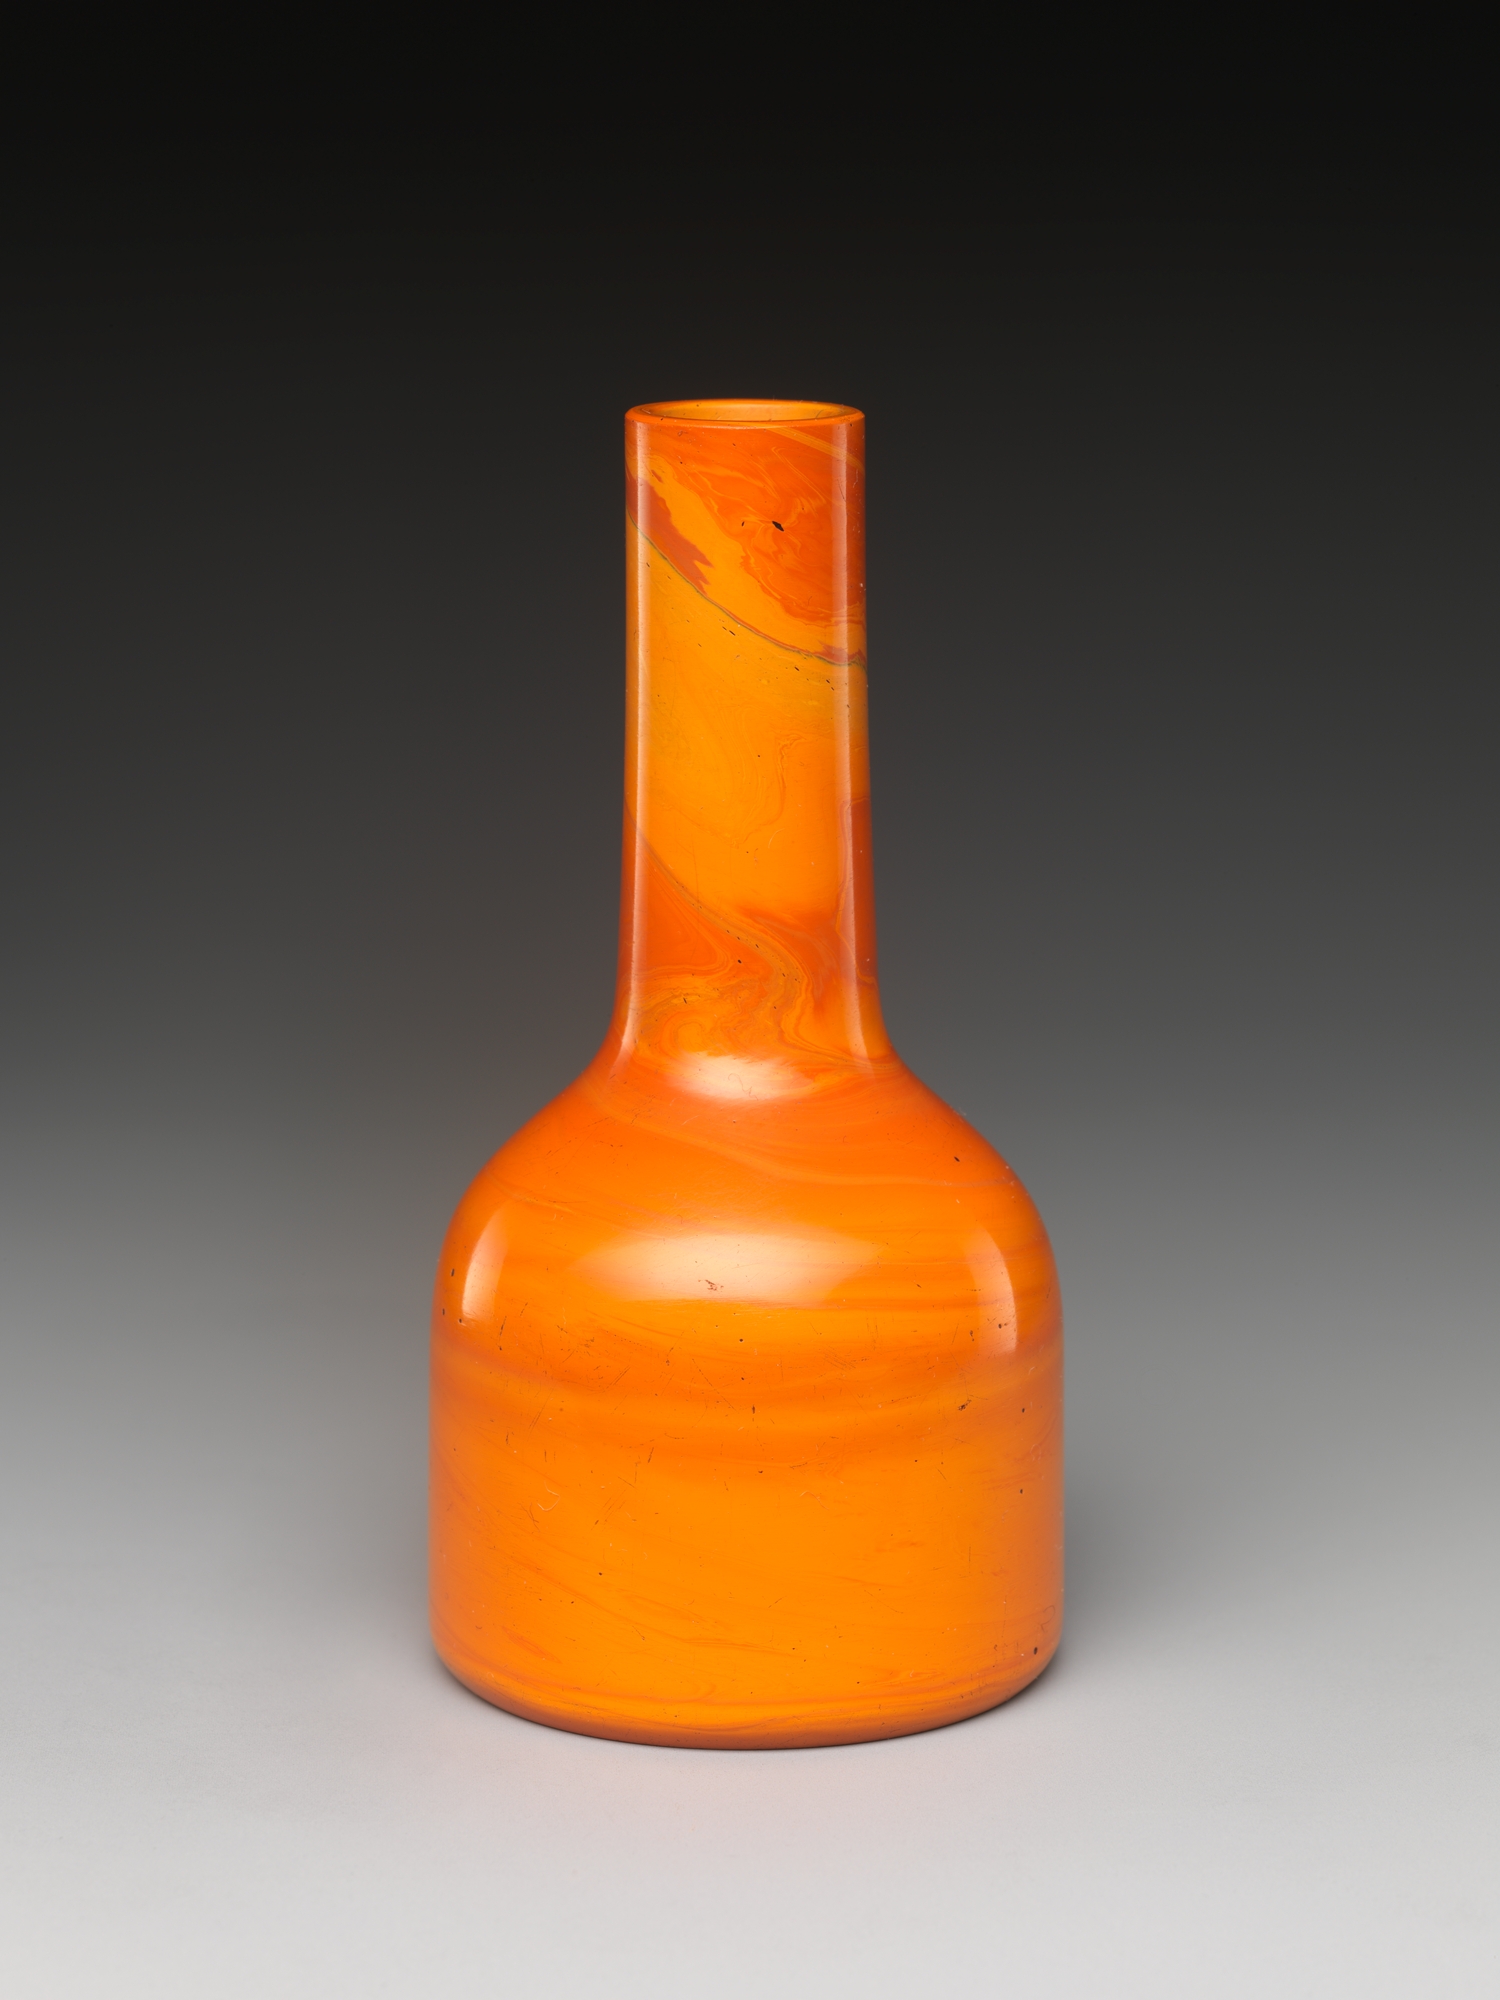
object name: bottle vase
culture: chinese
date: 1723-1735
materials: glass